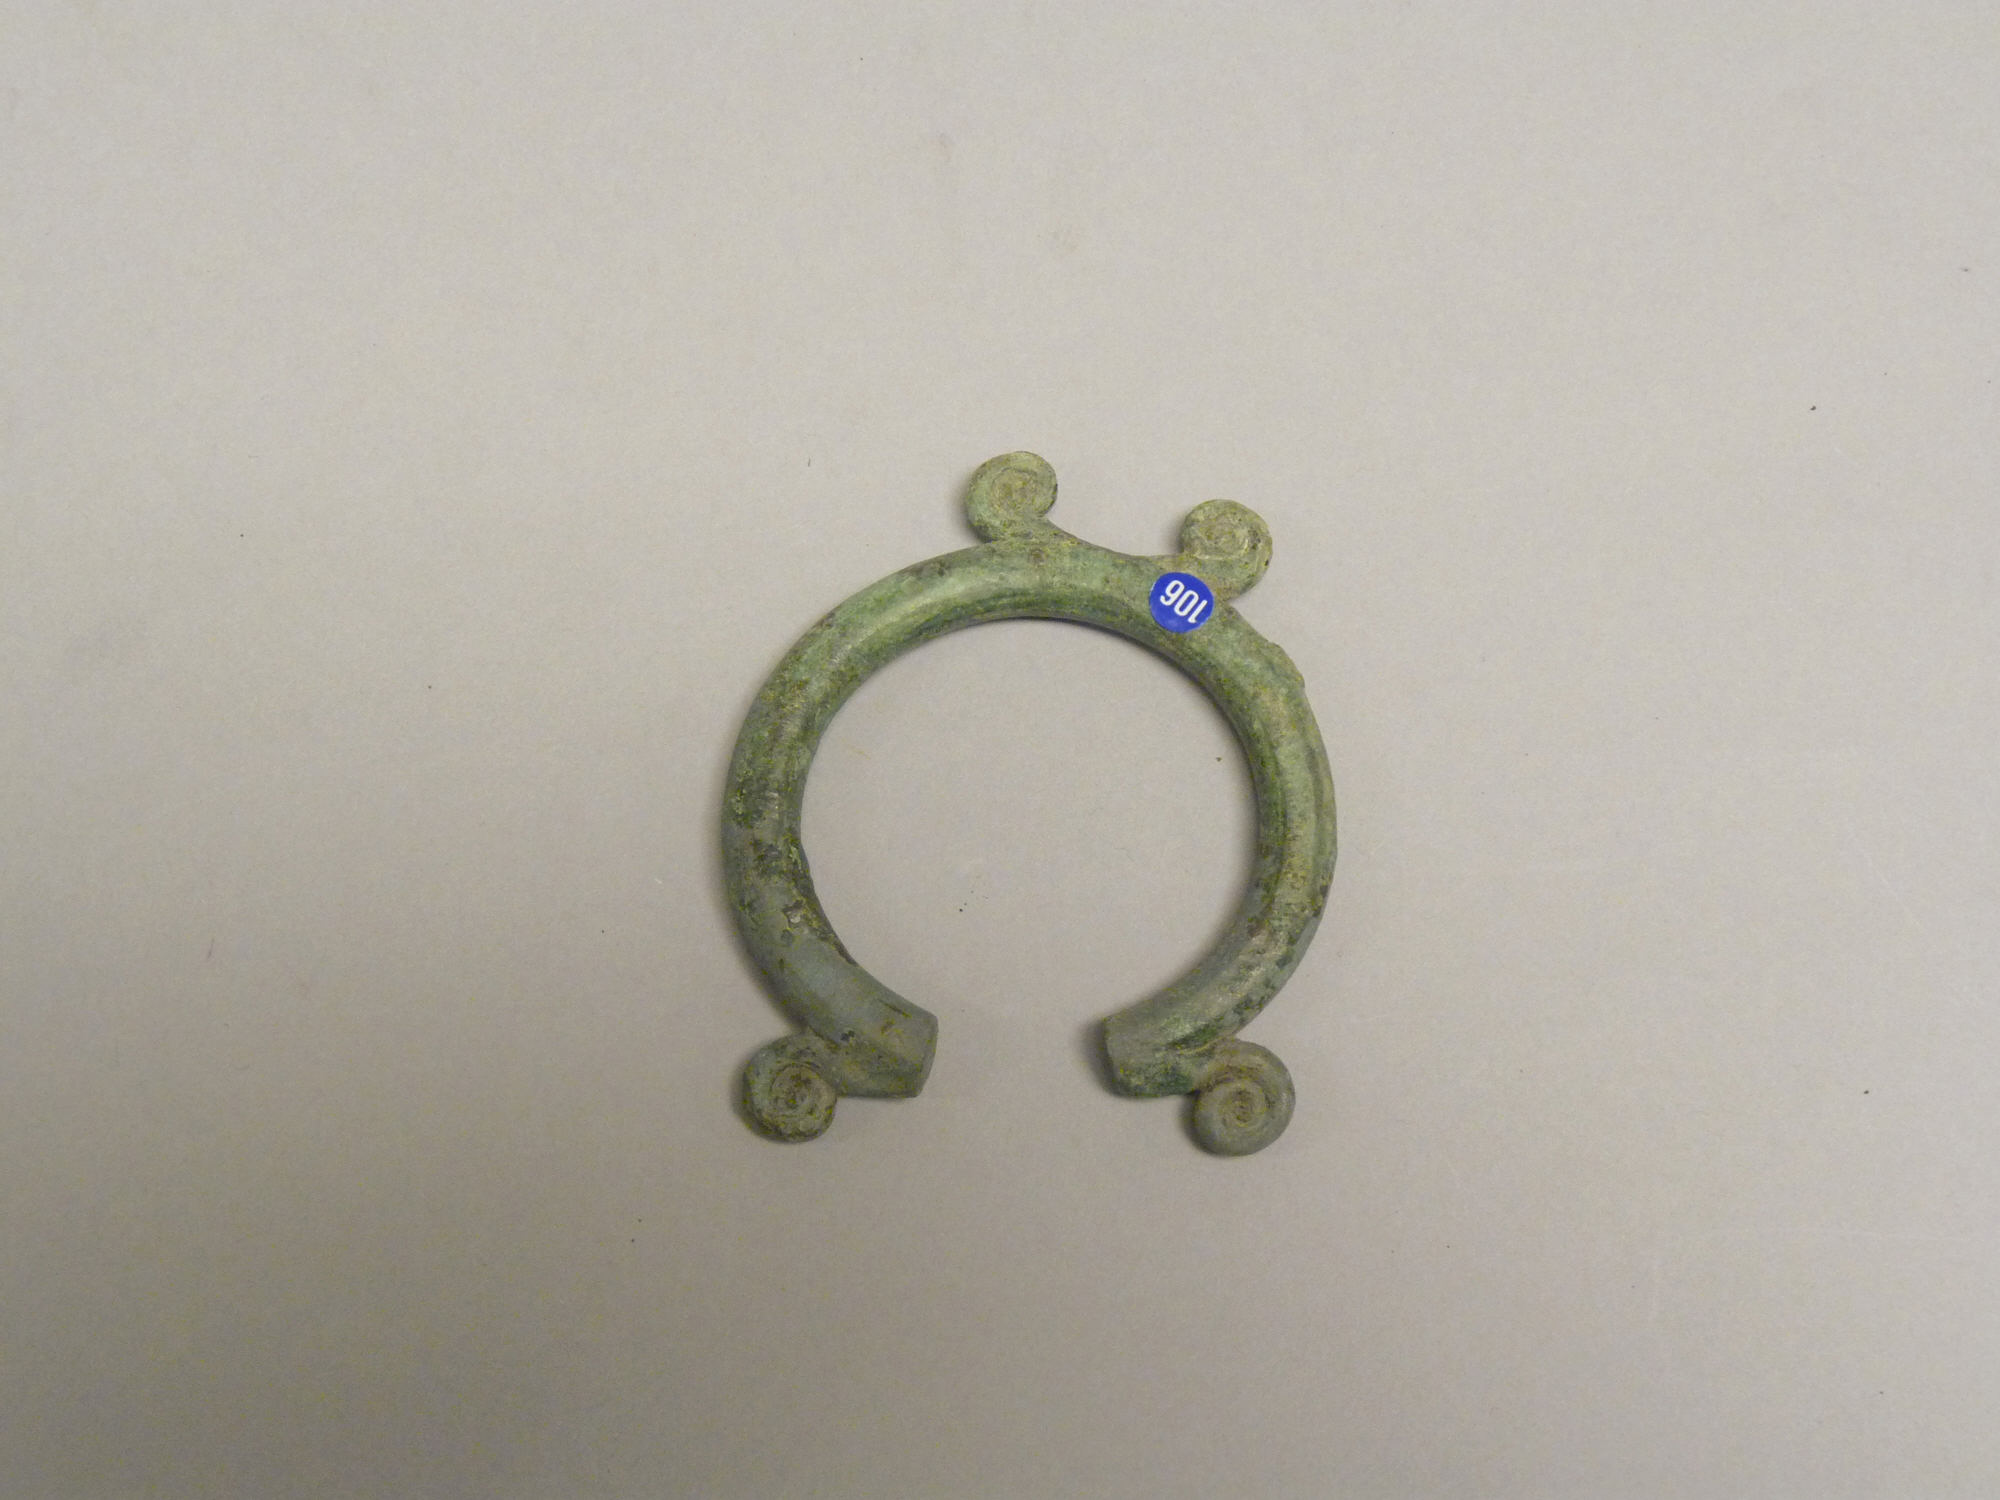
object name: bangle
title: Bangle with Small Spiral Ornaments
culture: thai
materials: bronze